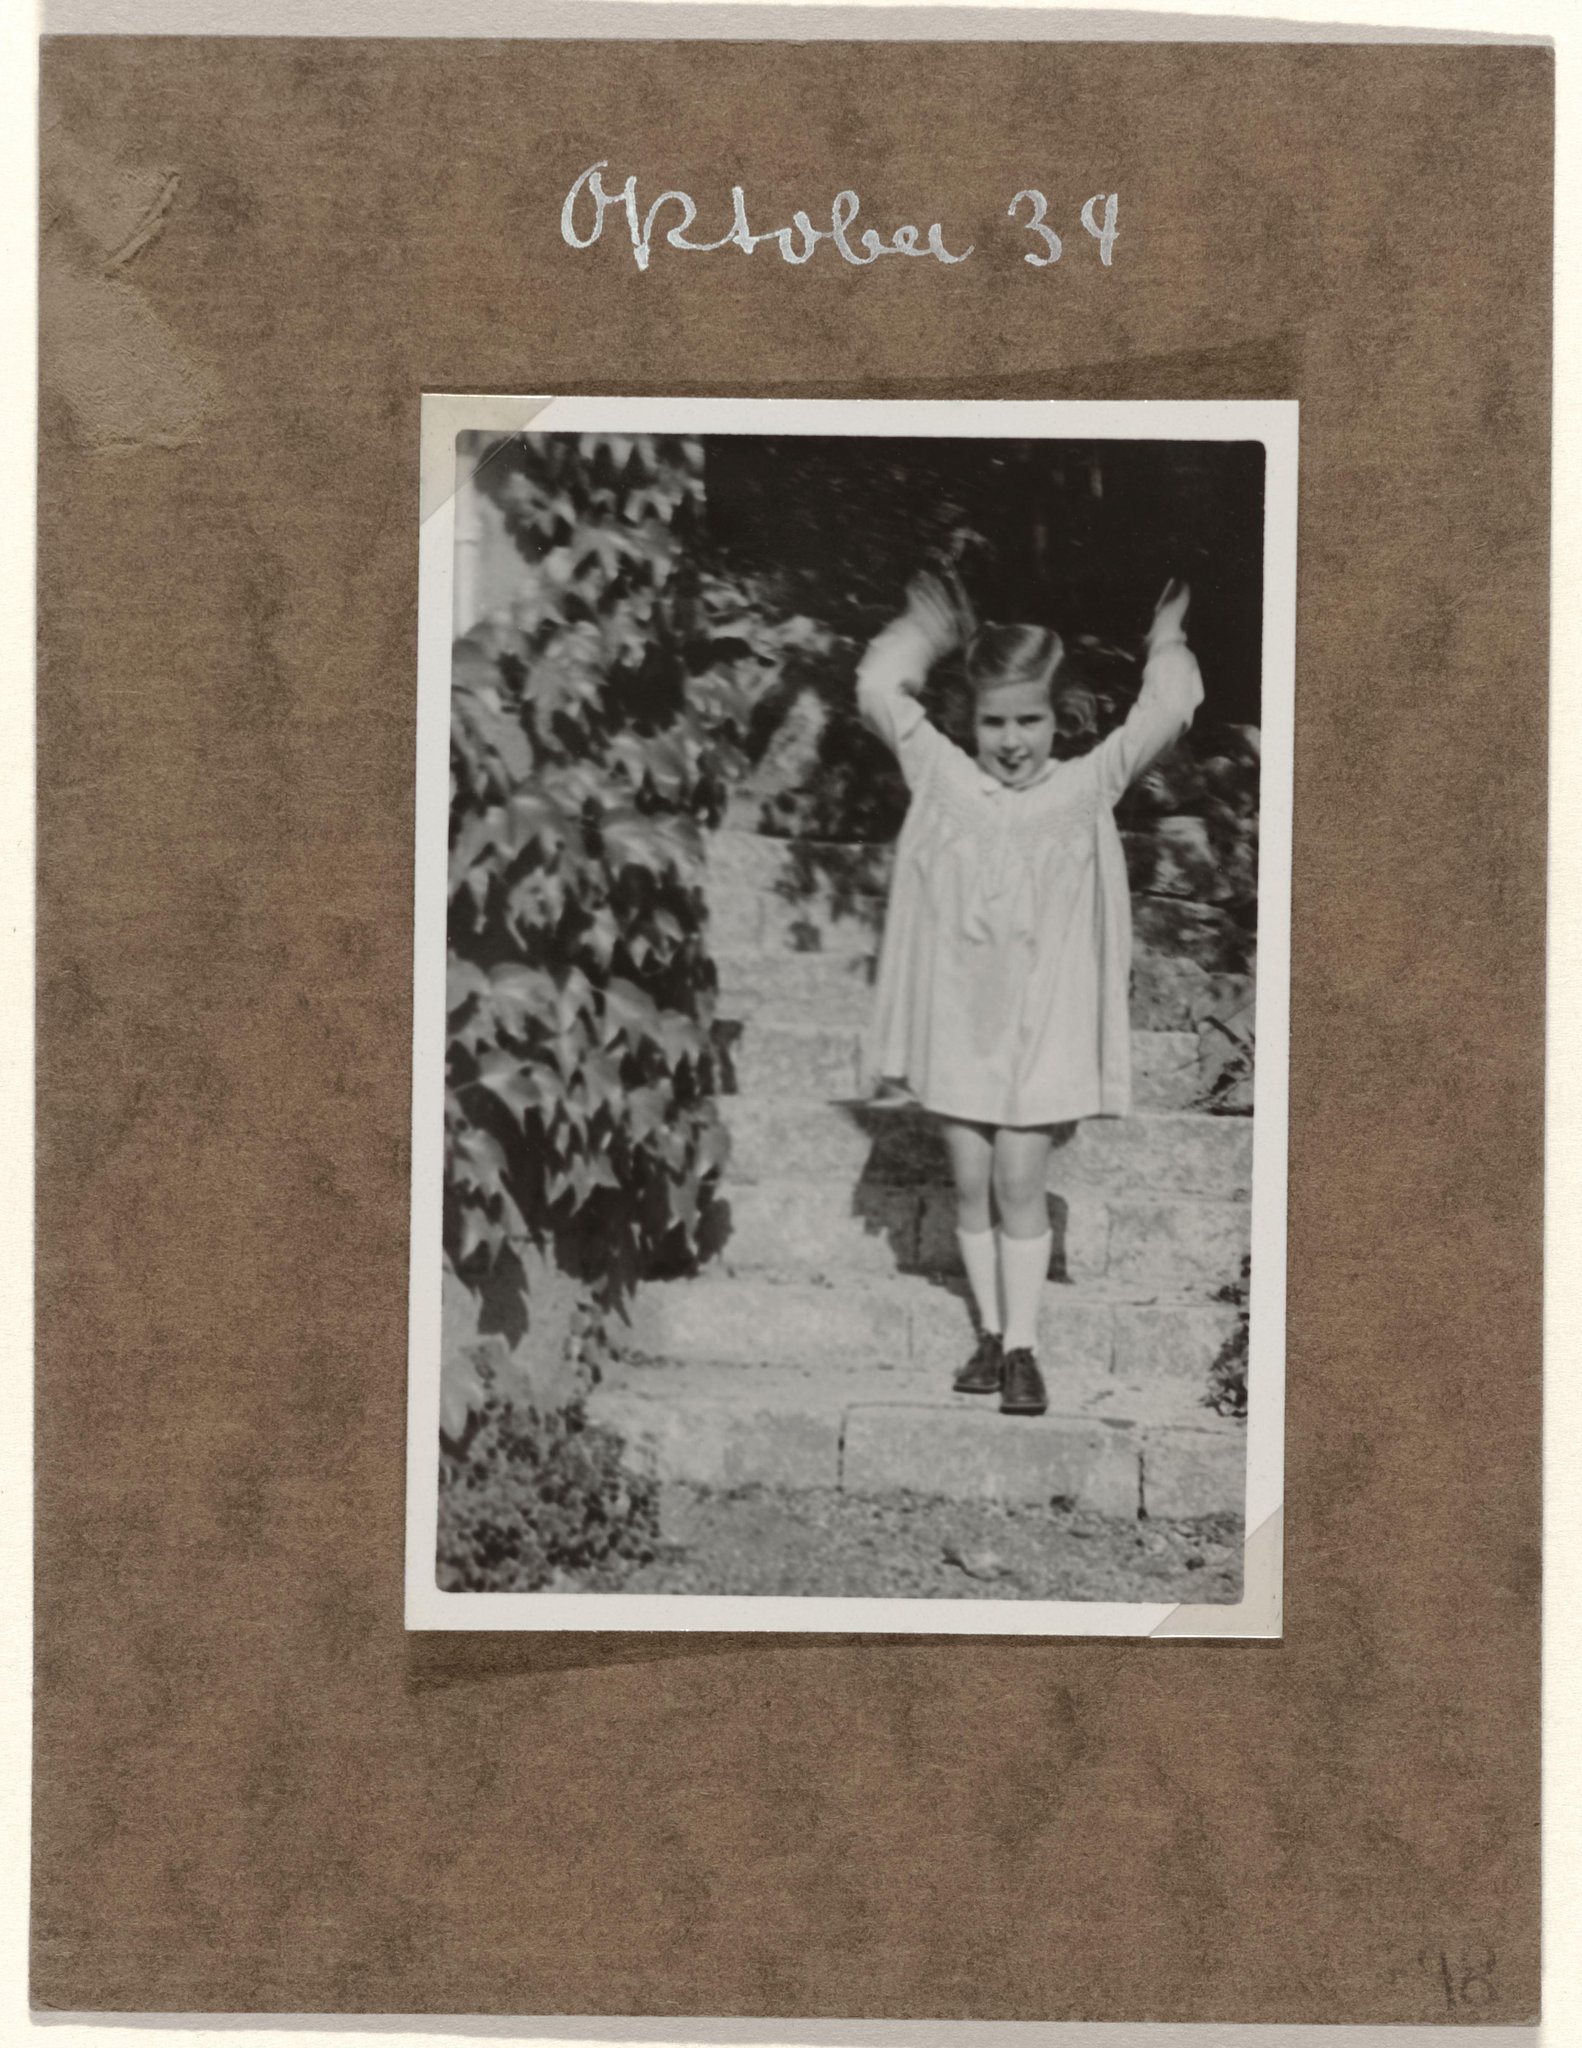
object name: photograph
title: Isabel Wachenheimer buiten bij een stenen trap, in Stuttgart oktober 1934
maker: Anonymous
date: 1910-1934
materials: photographic support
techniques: gelatin silver print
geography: stuttgart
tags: leiden, isabel wachenheimer-elon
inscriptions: date: ‘Oktober 34’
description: Isabel Wachenheimer bij een stenen trap met begroeiing.